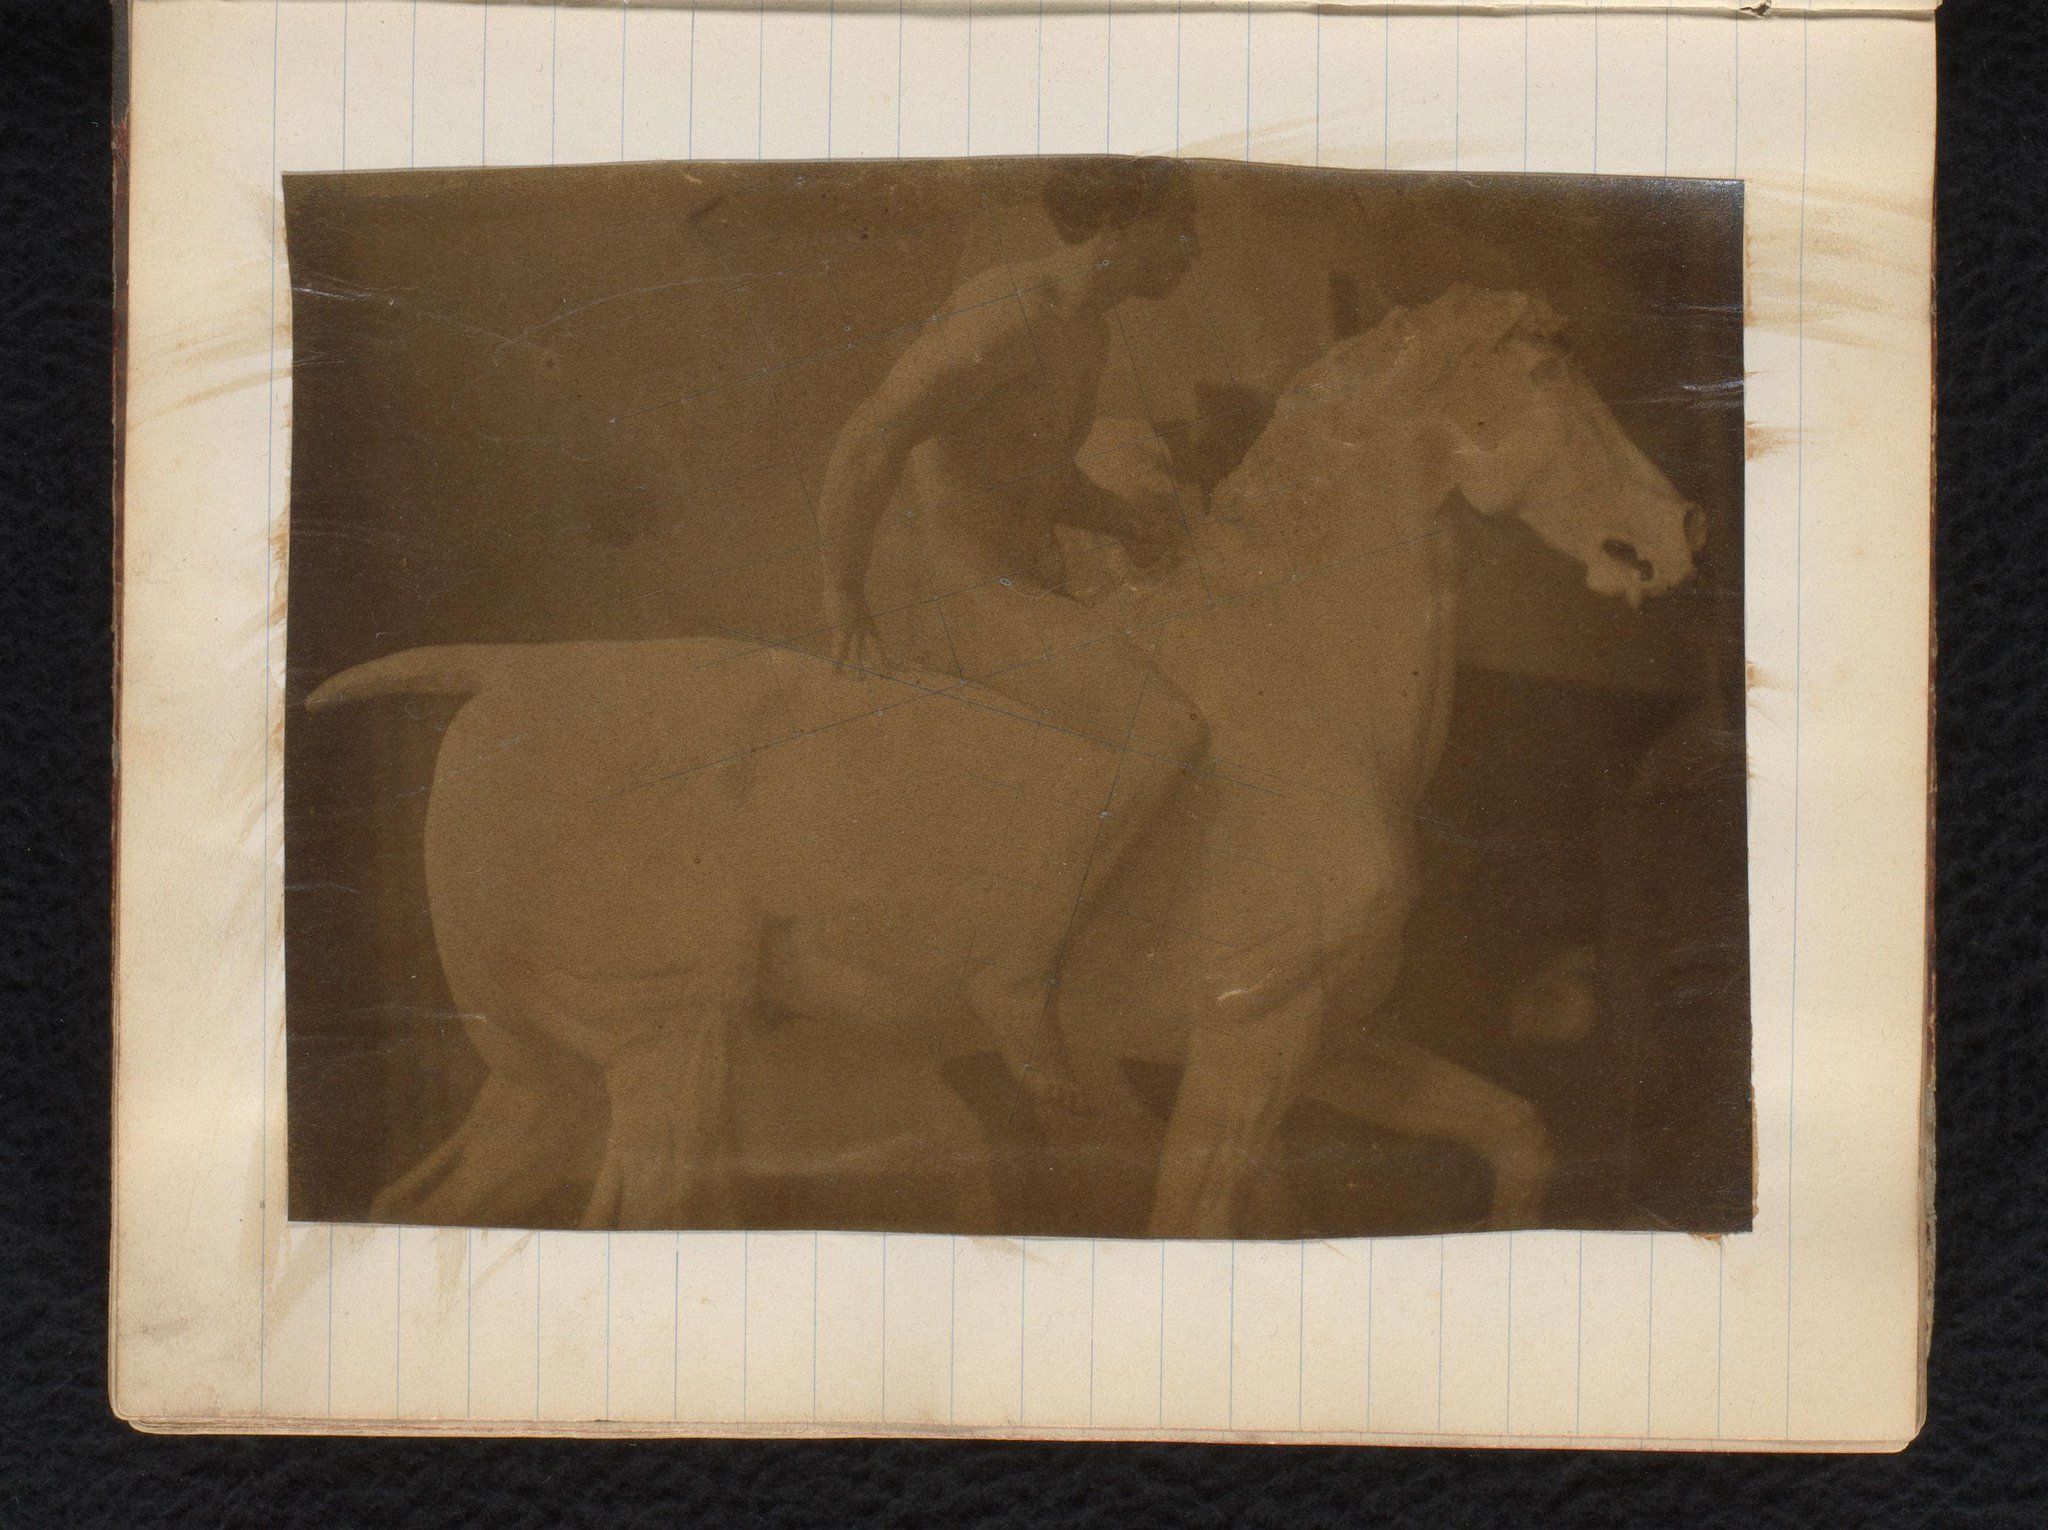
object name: photograph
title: Studie van een mannelijk naaktmodel, gezeten op een gipsen paard, in het atelier van Jacques de Lalaing, mogelijk voorstudie voor Ruiterportret, Museum voor Schone Kunsten Gent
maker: jacques lalaing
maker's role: painter, sculptor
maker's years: 1858-1917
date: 1883-1914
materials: pencil, photographic support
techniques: albumen print, drawing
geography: brussels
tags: adult man, sculpture, artist (in general) working from nude model